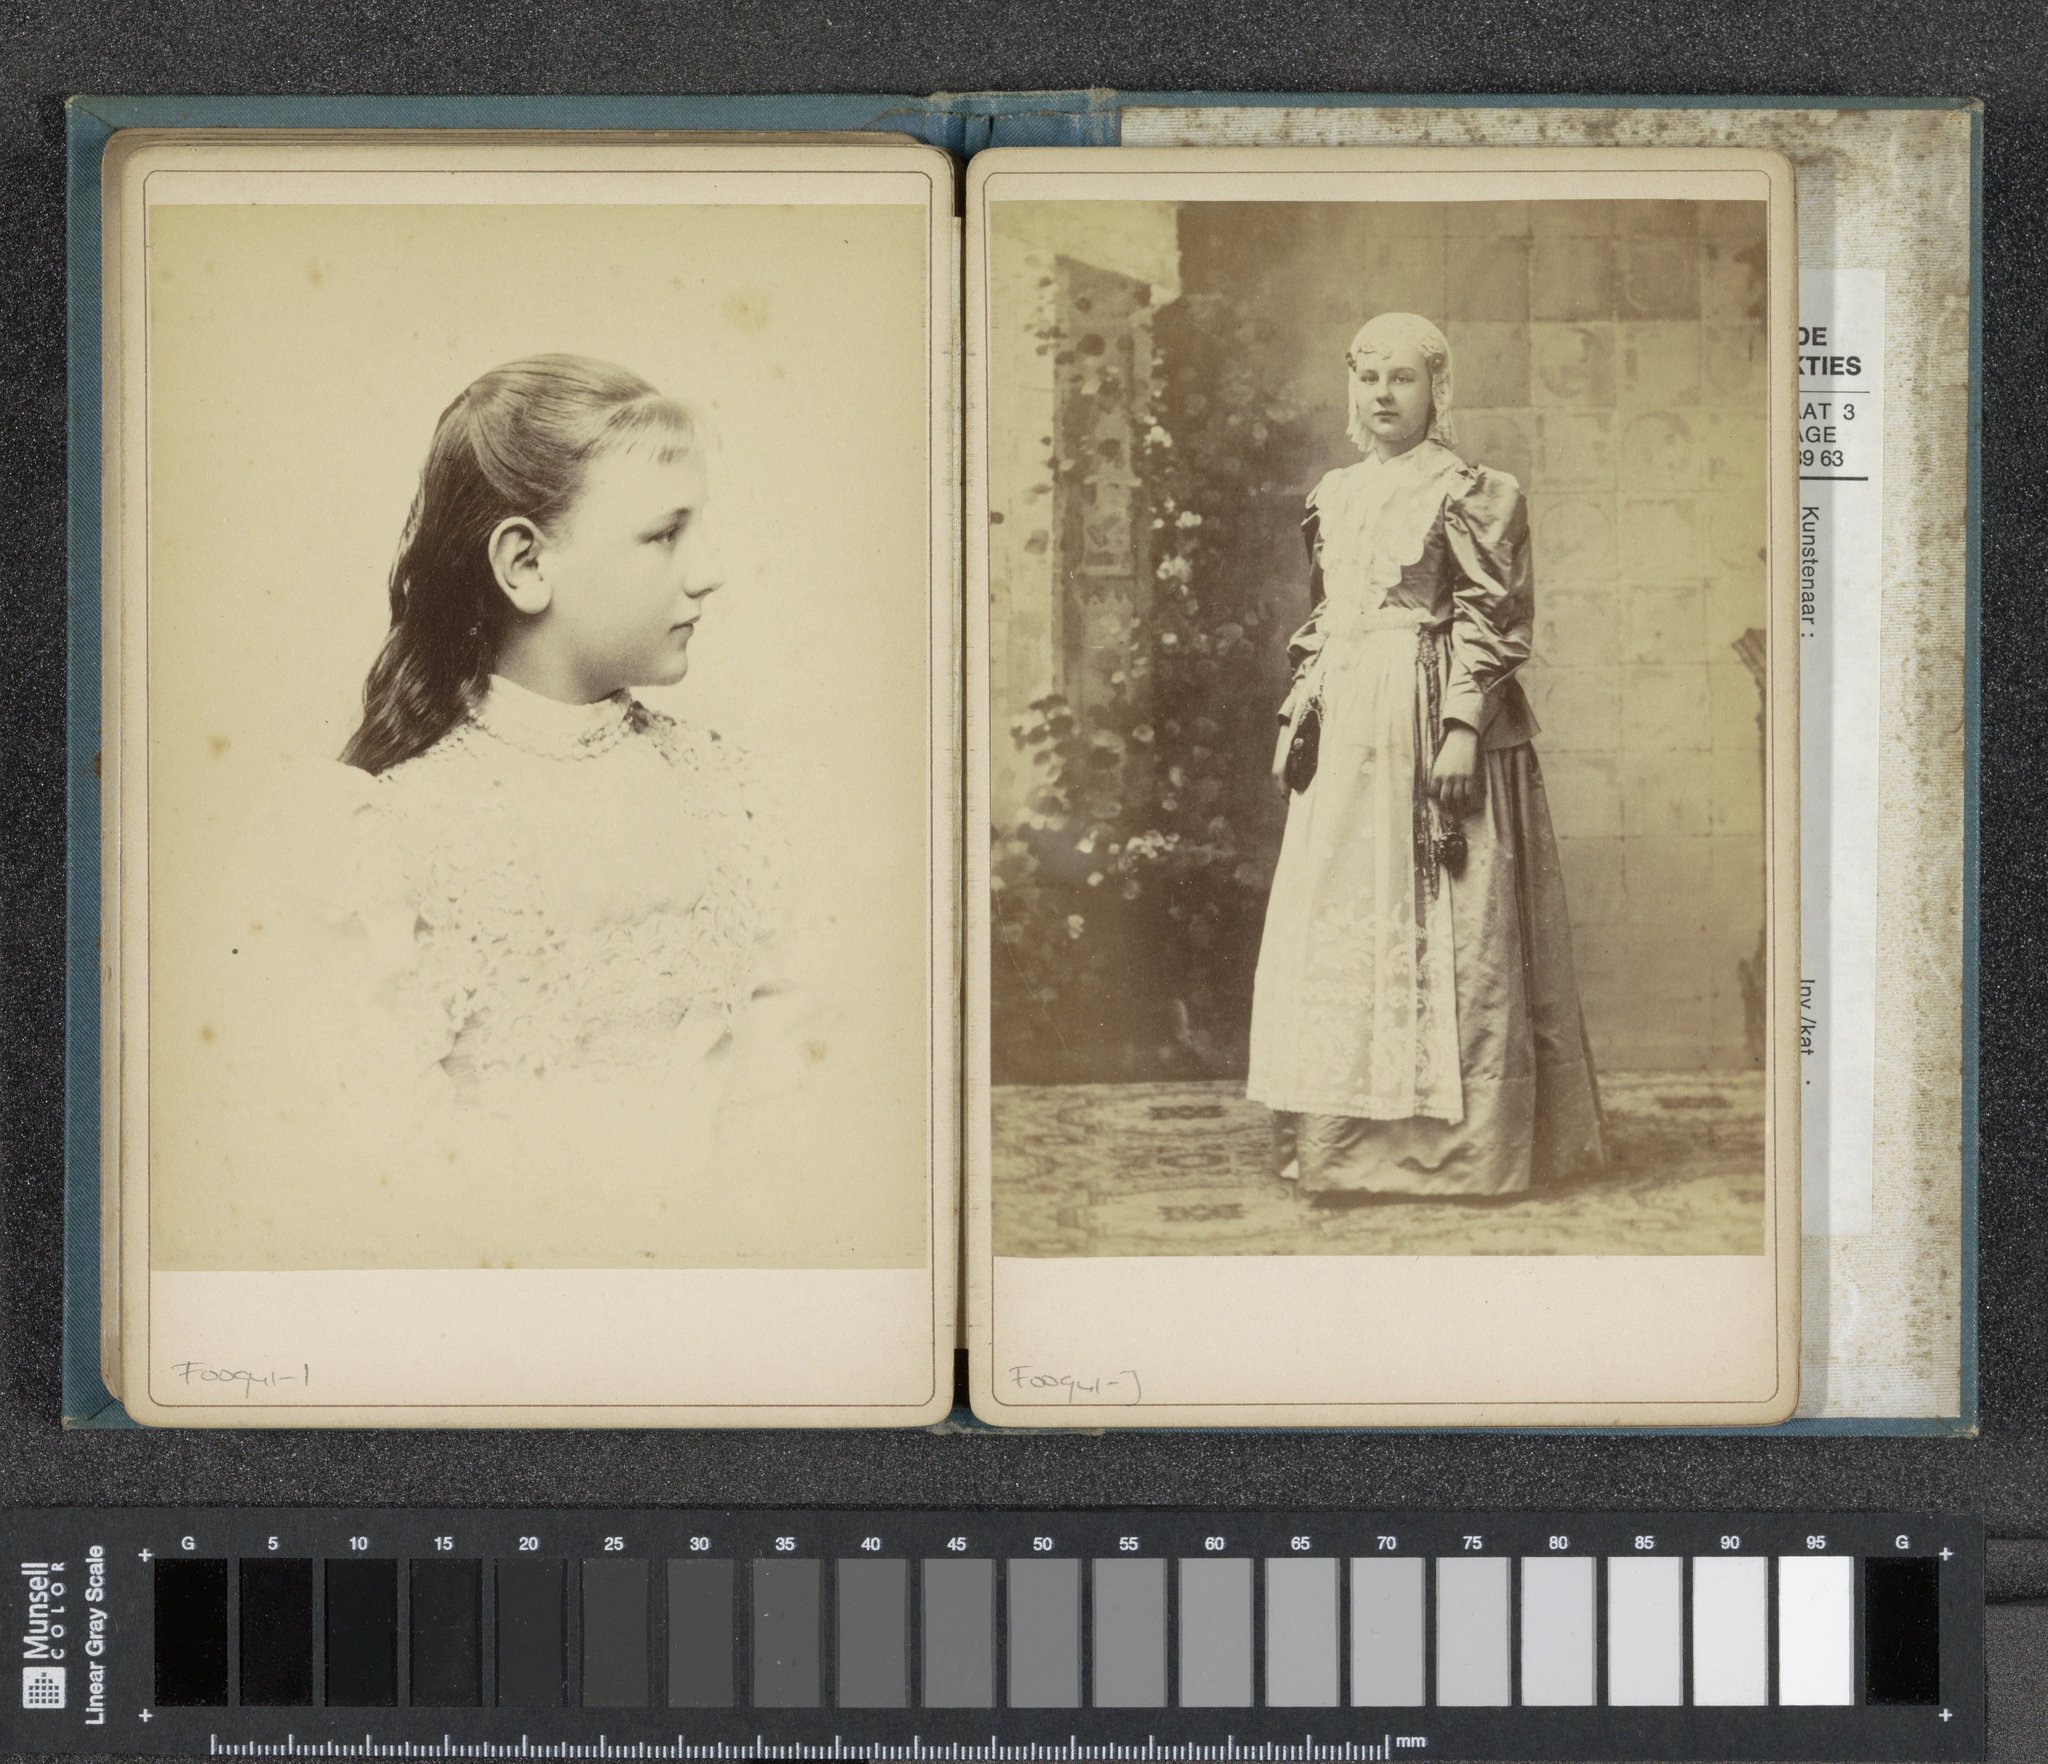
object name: photograph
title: Portret van prinses Wilhelmina, staand in Friese klederdracht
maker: Anonymous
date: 1892-1893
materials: cardboard, photographic support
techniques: albumen print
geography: netherlands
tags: the hague, wilhelmina of the netherlands, folk costume, regional costume (+ women's clothes), child, ruler, sovereign - bb - female ruler, netherlands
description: Onderdeel van Fotoalbum met opnames van prinses Wilhelmina als kind tot aan haar inhuldiging in 1898.